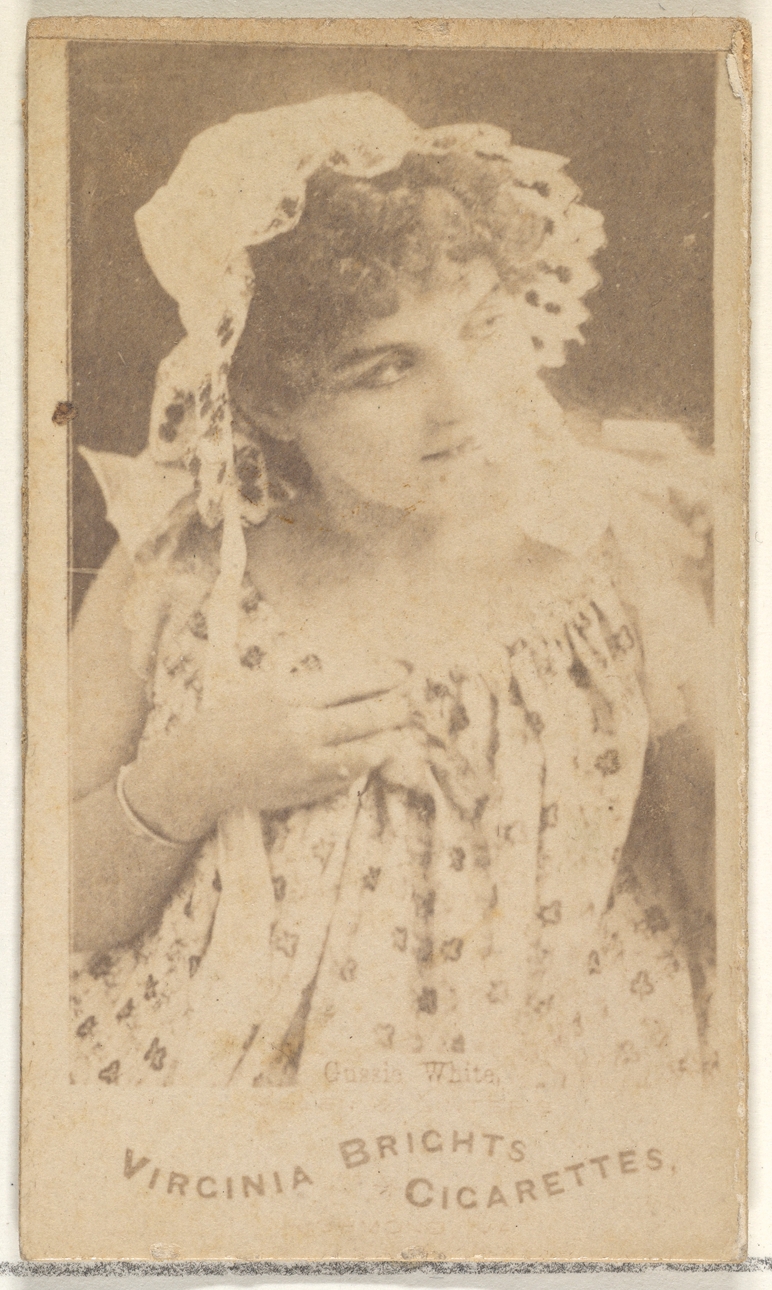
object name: photograph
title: White, from the Actors and Actresses series (N45, Type 1) for Virginia Brights Cigarettes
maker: allen & ginter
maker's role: publisher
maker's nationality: american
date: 1888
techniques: albumen silver print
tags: portraits,women,actresses